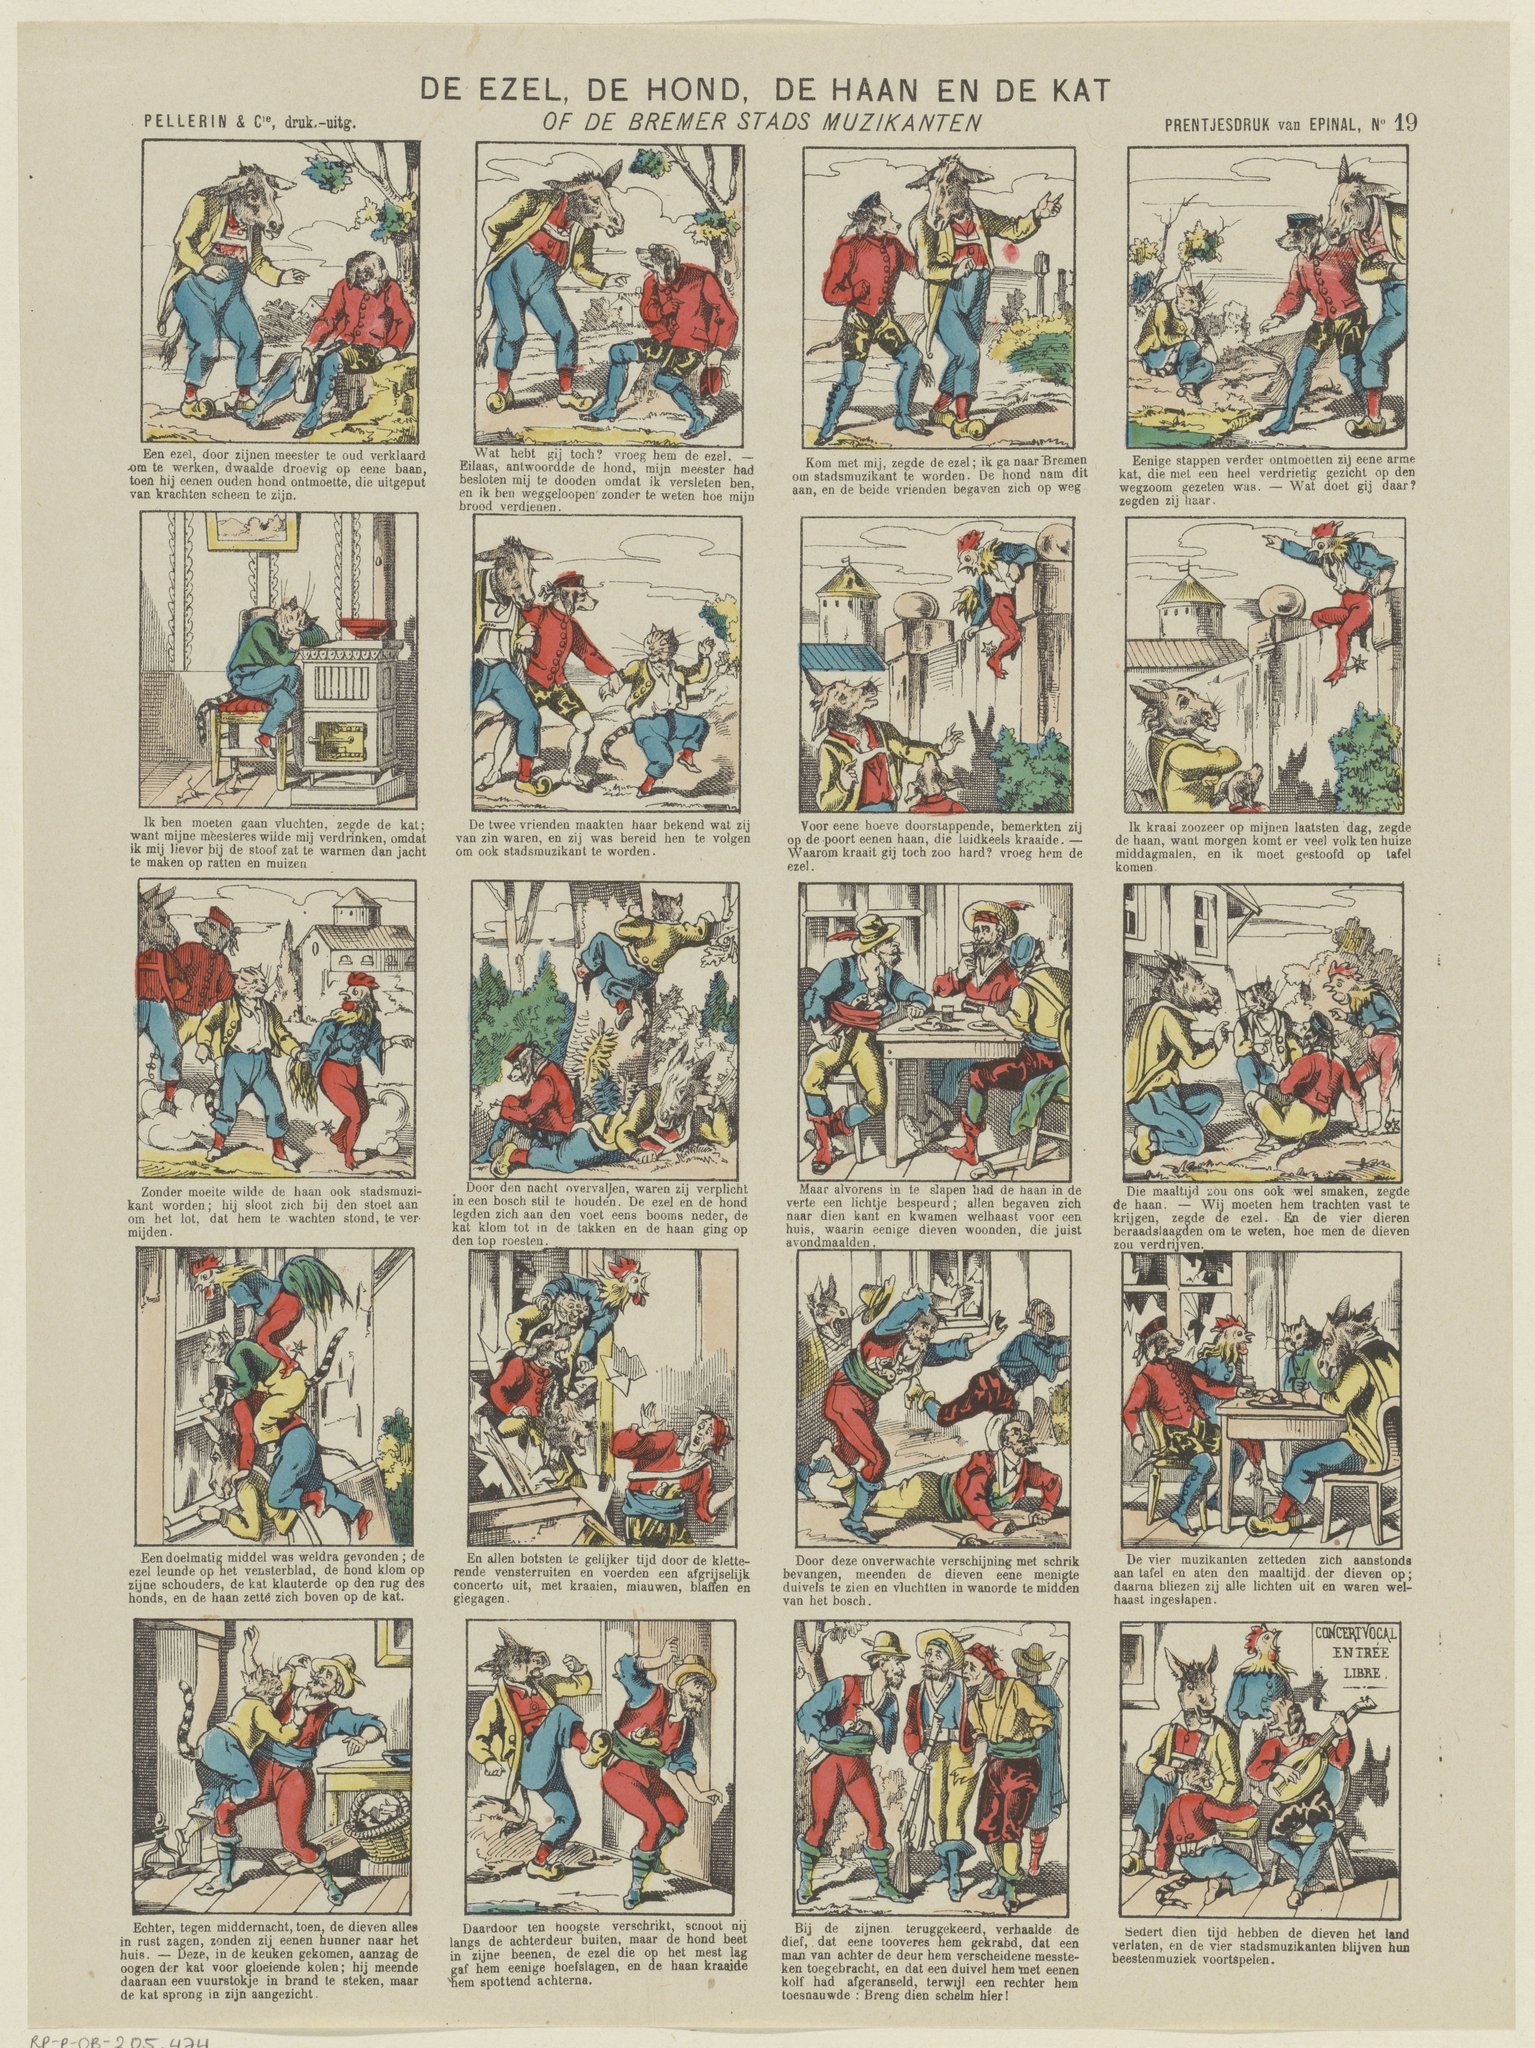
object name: popular print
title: De ezel, de hond, de haan en de kat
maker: Anonymous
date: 1902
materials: paper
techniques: colour, letterpress printing, lithograph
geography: epinal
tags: cat, ass, donkey, fowl (cock, hen, chicken, etc.), tales and fairy tales, dog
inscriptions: collector's mark: Lugt 2760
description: Blad met 20 voorstellingen uit het sprookje van de ezel, de hond, de haan en de kat: de Amsterdammer stadsmuzikanten. Onder elke afbeelding een onderschrift. Genummerd rechtsboven: No 19.